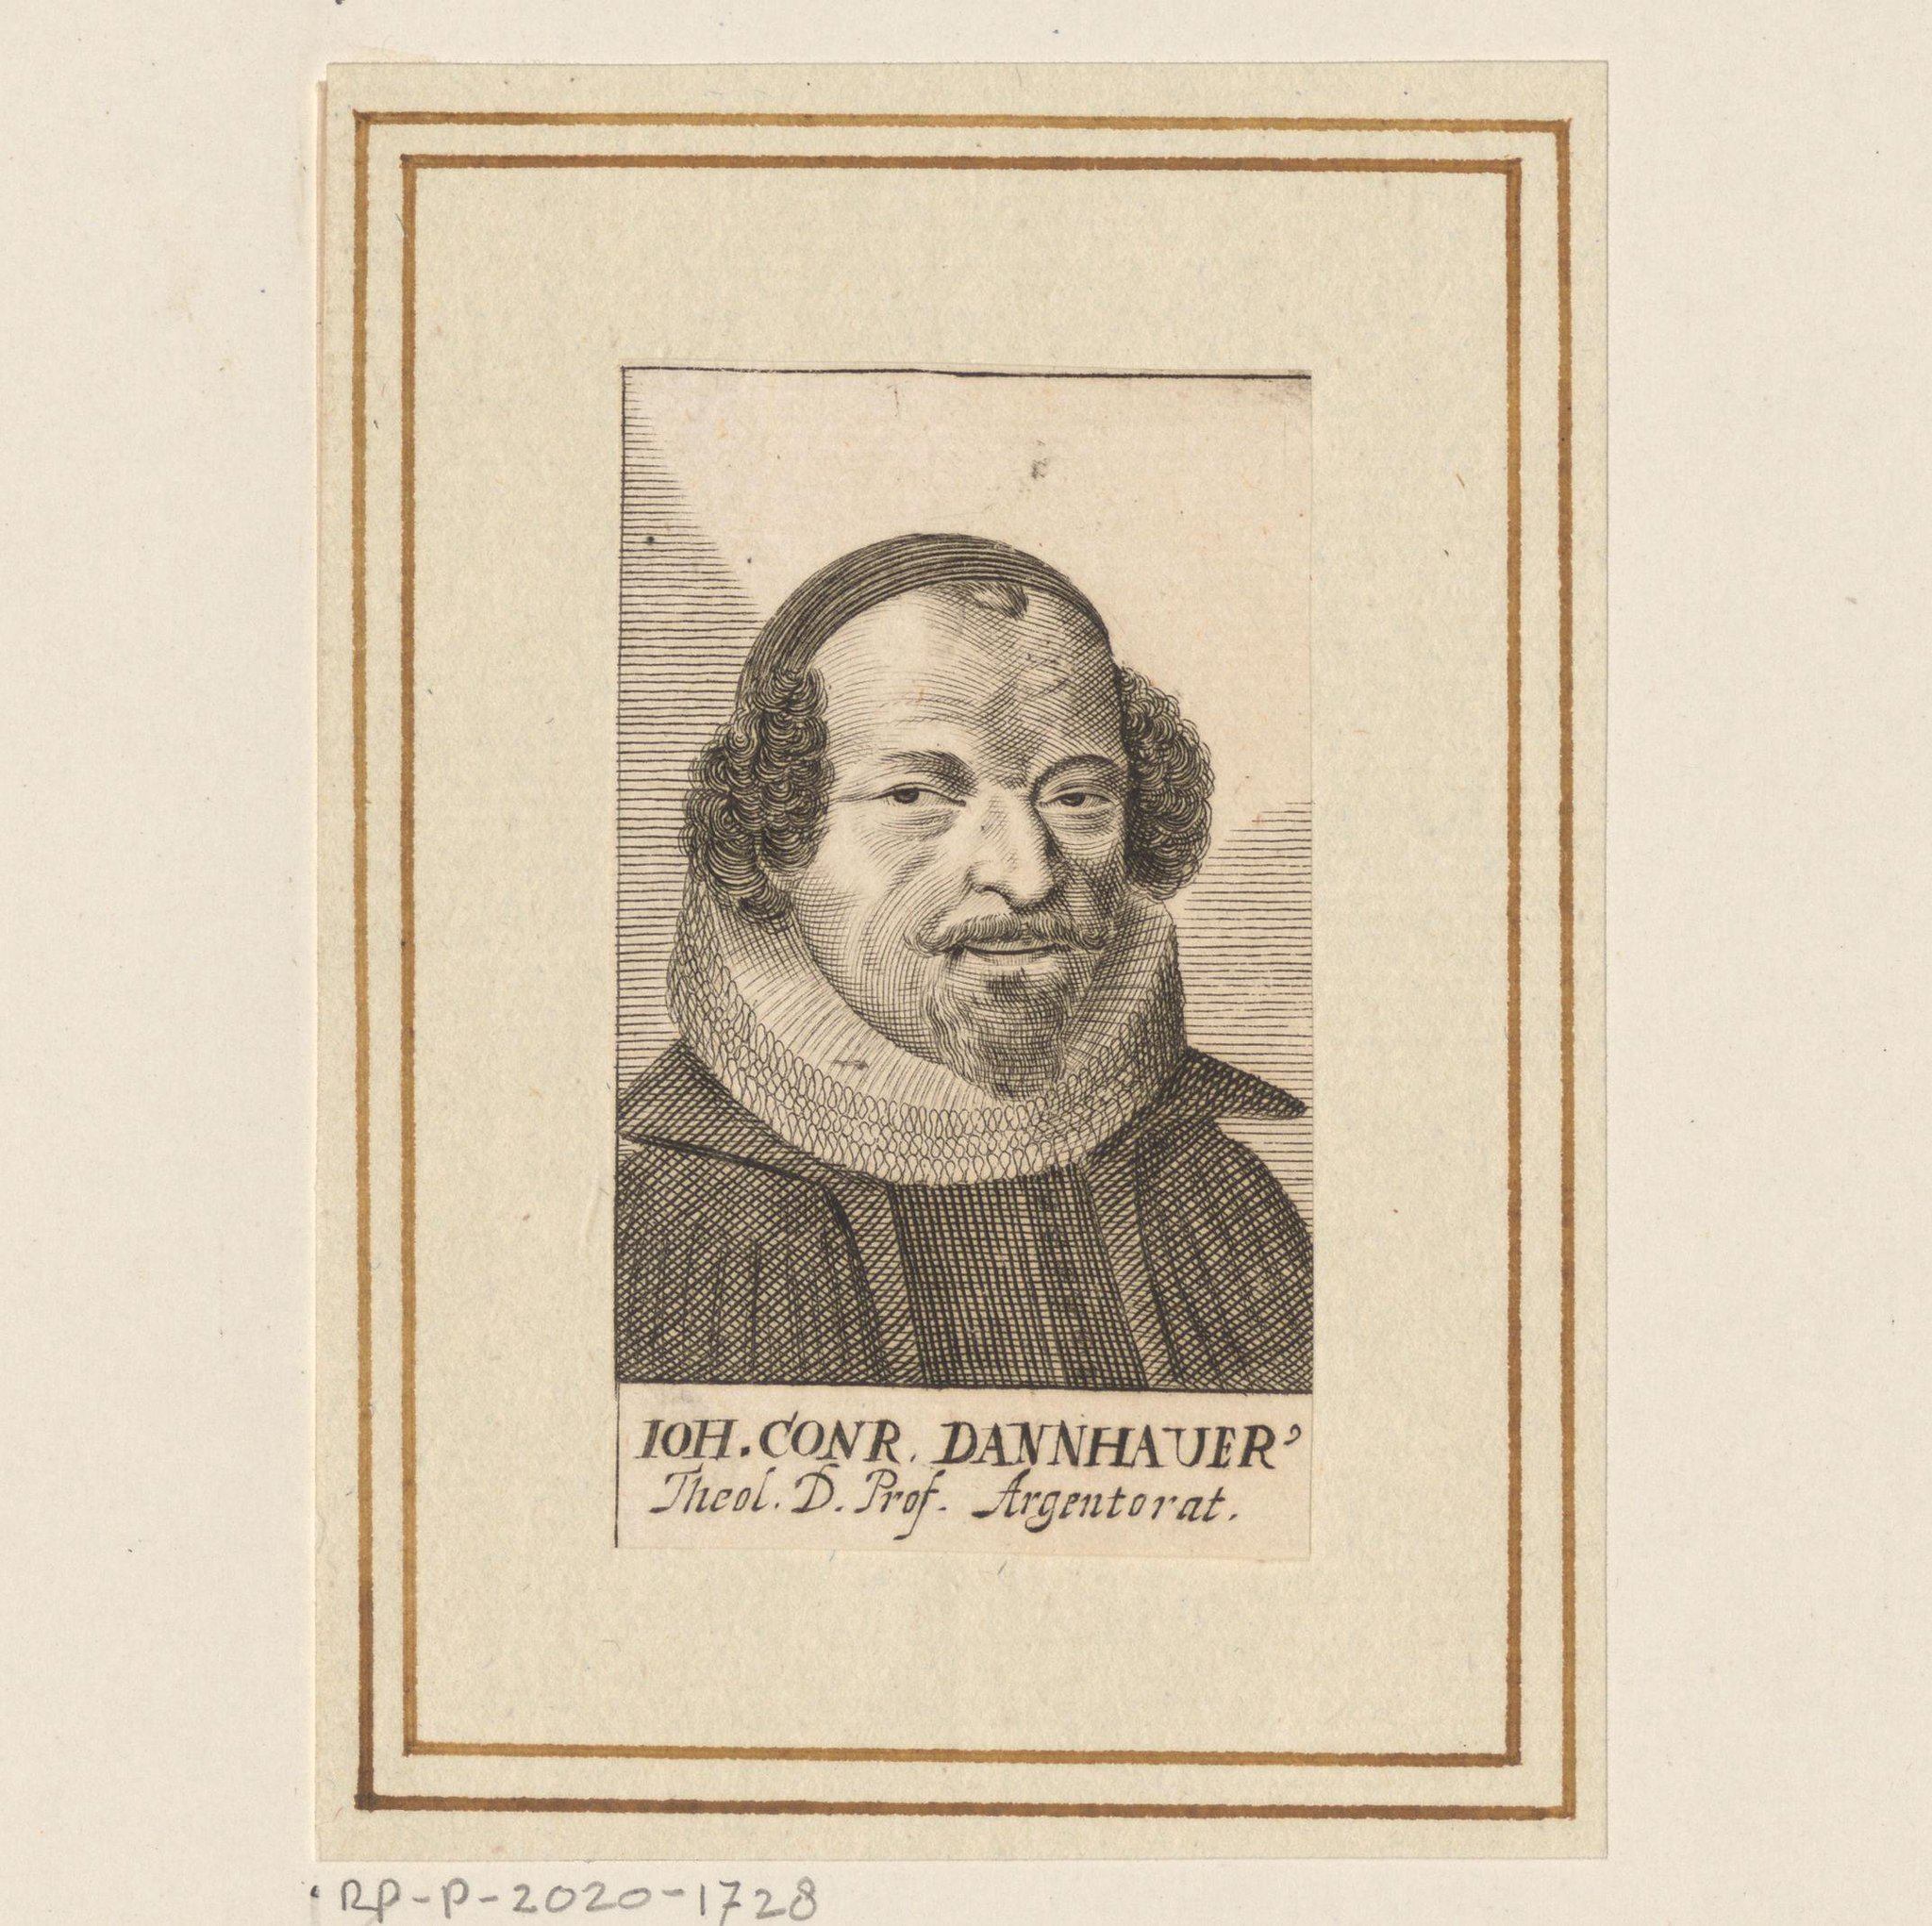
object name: print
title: Portret van Johann Conrad Dannhauer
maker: Anonymous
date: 1688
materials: paper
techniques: engraving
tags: johann conrad dannhauer, theologian, historical persons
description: Prent maakt deel uit van een grotere prent die later is verknipt. Prent is ook gebruikt in: Freher, Paul. Theatrum virorum eruditione clarorum. Neurenberg: Johann Hoffmann, 1688.